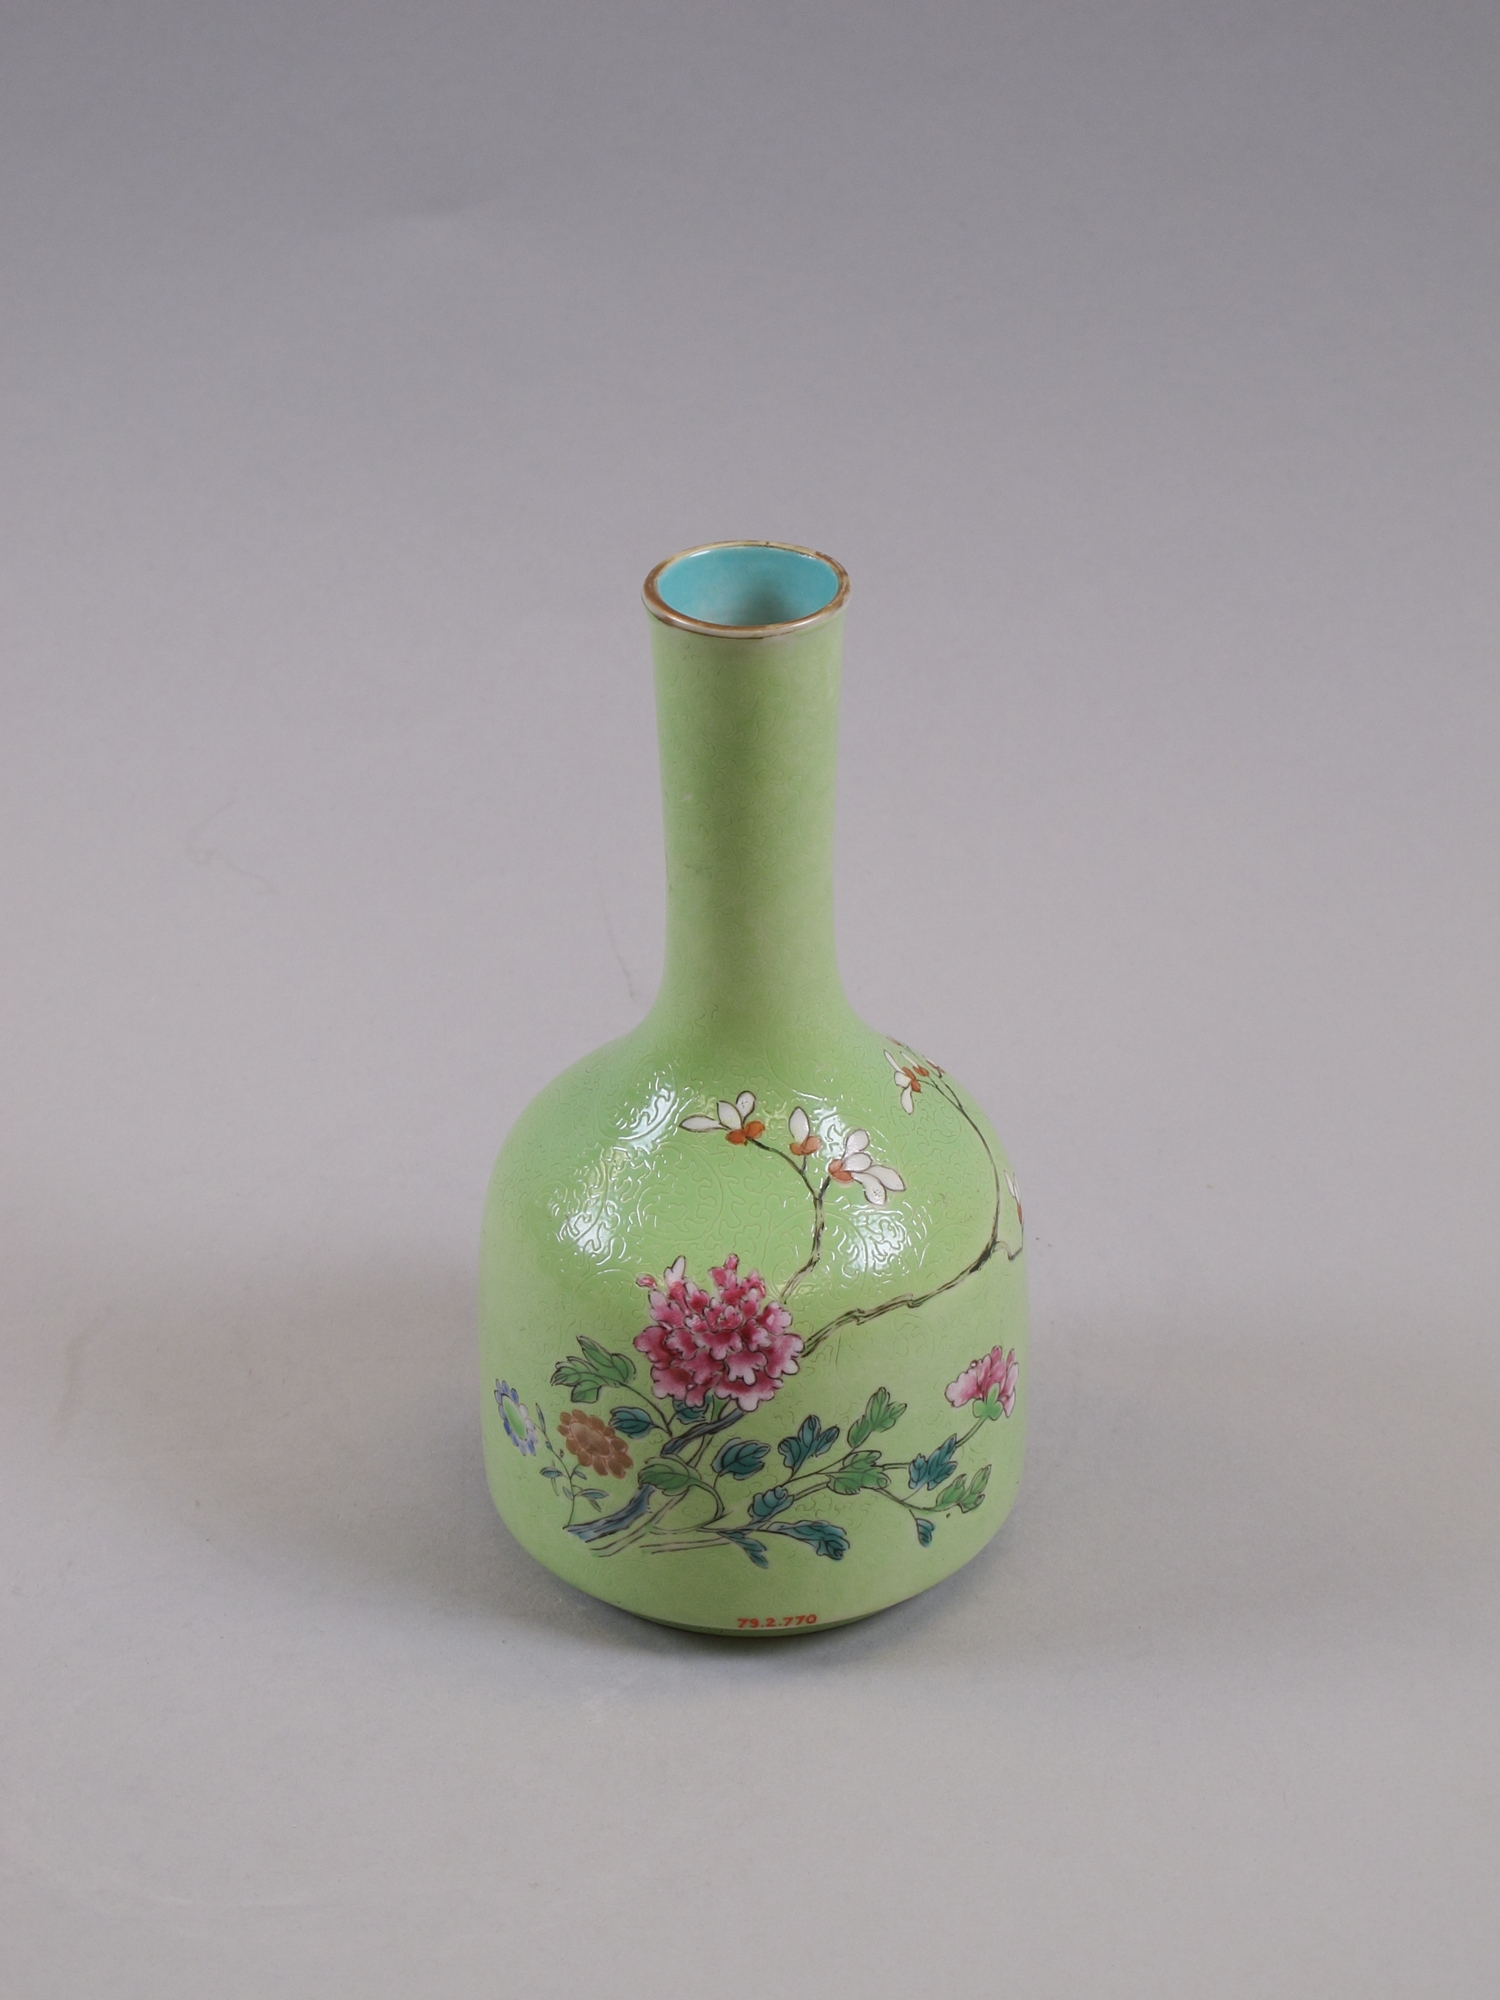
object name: vase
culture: chinese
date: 1801-1850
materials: enamel, porcelain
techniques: engraving, overglaze, painting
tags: flowers,leaves